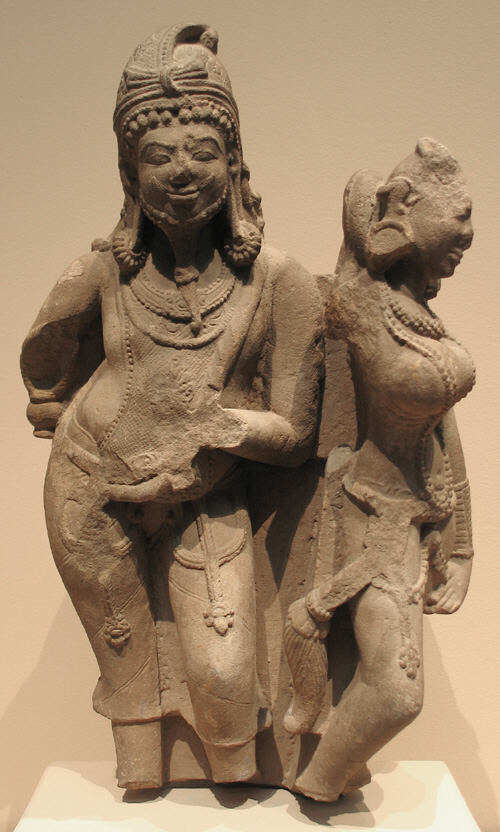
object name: stele fragment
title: The God Danda and the Goddess Niksubha (Attendants of Surya, the Sun God)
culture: indian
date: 1001-1100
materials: stone